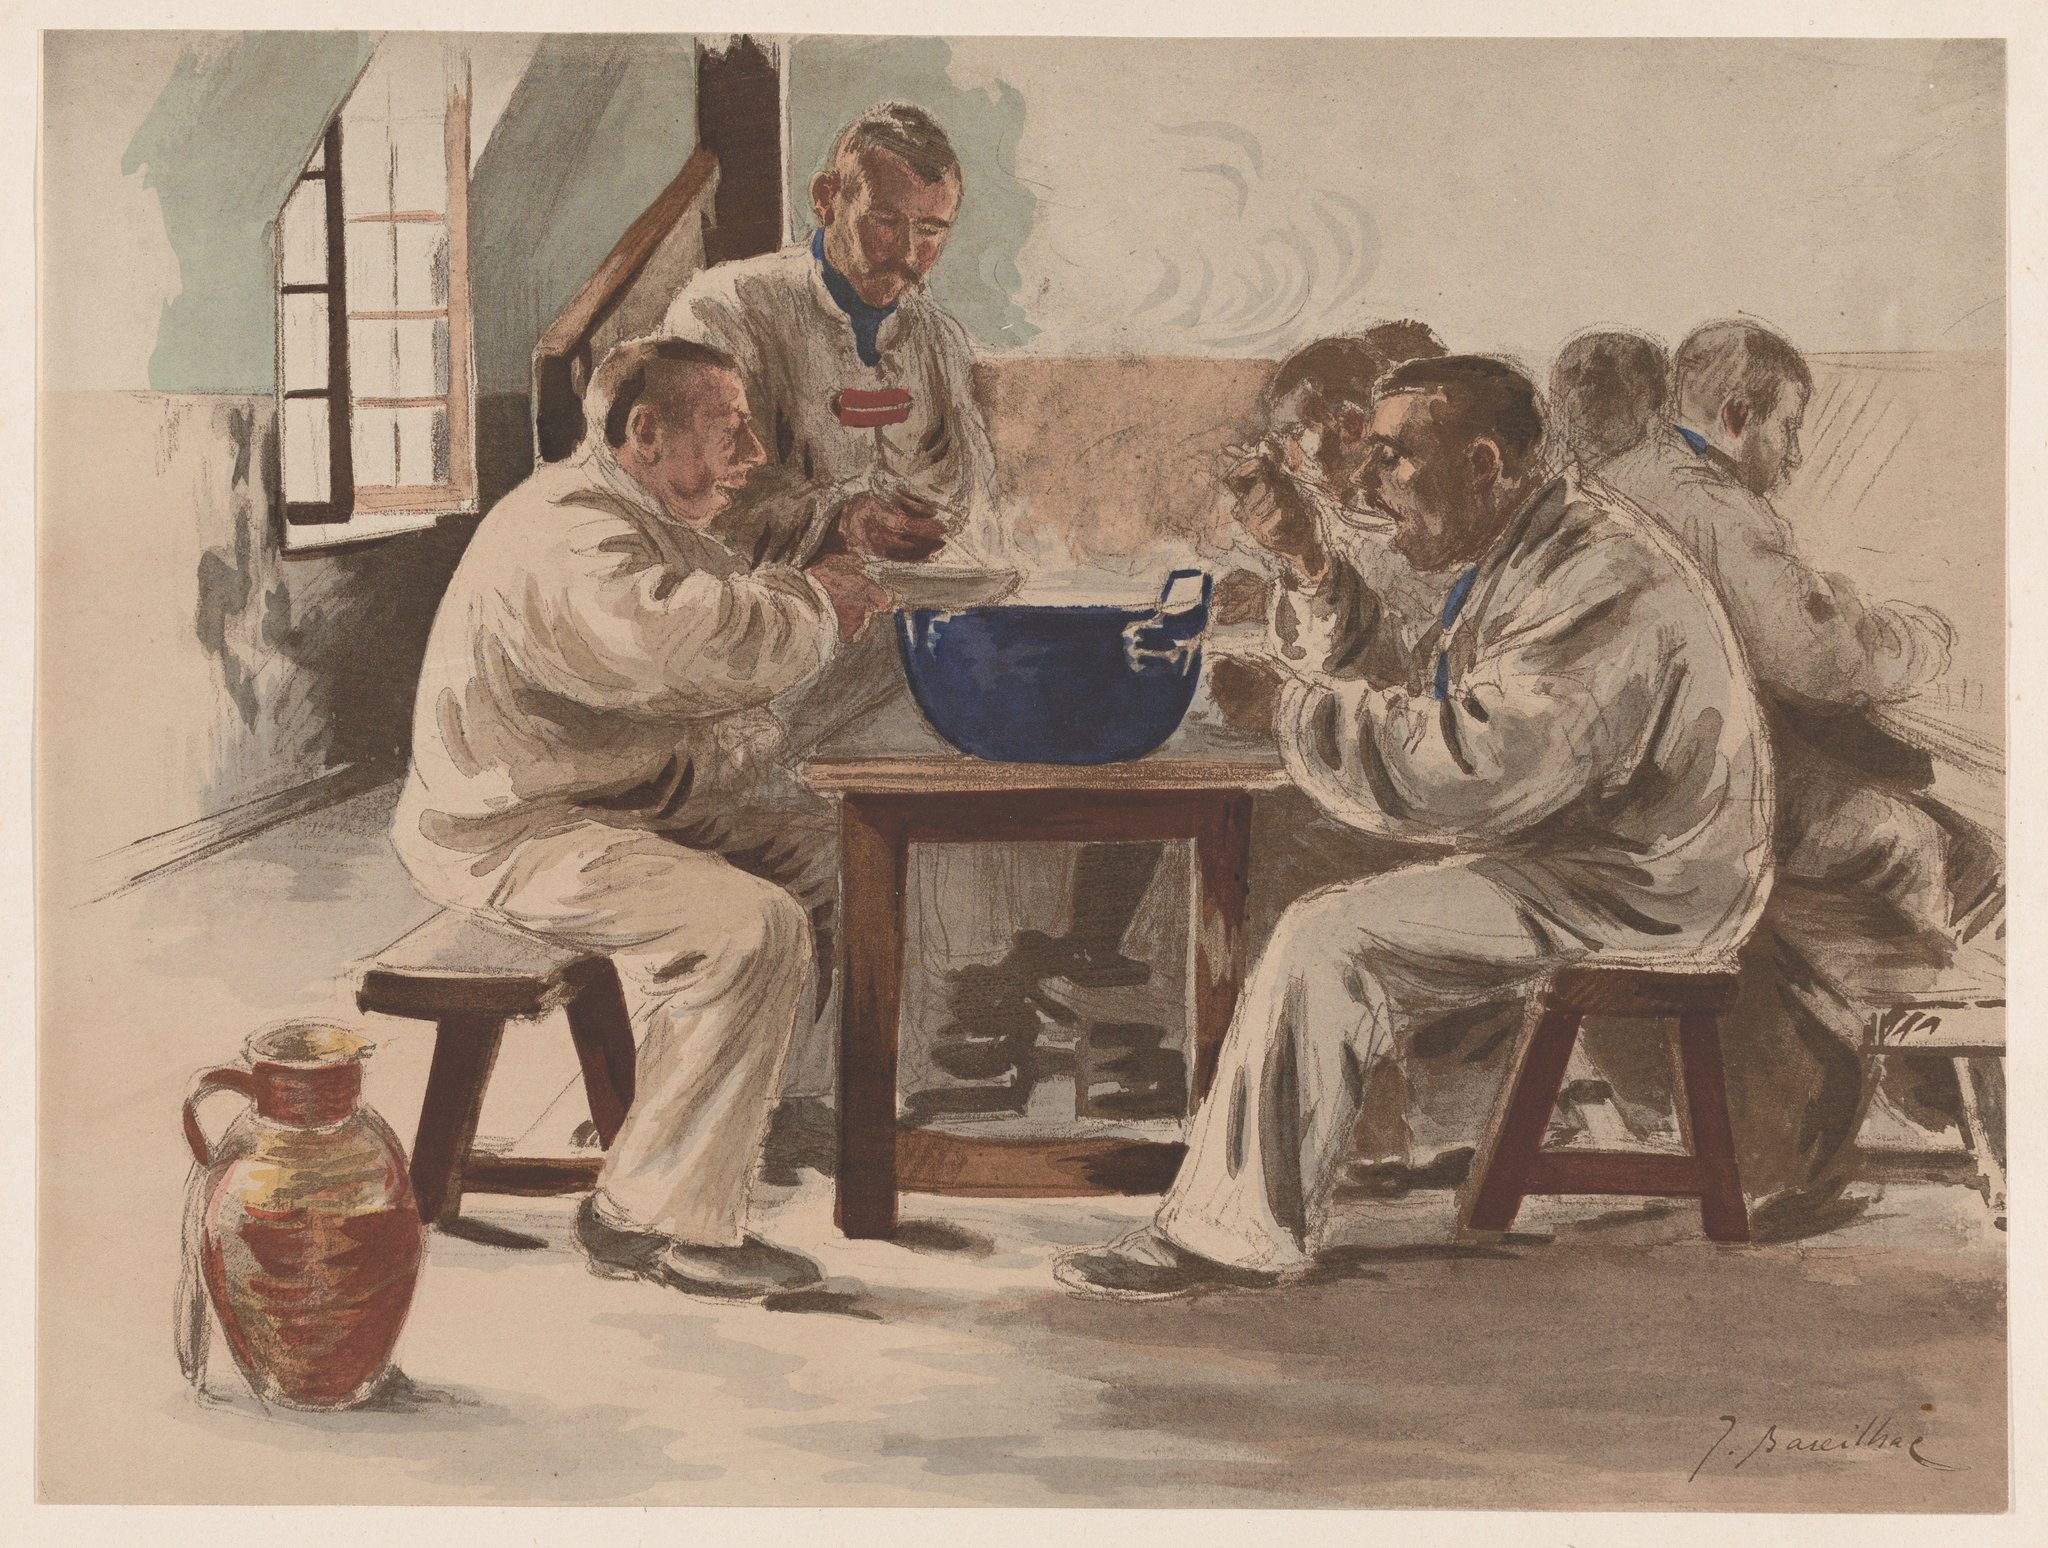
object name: print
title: La soupe à la chambrée, from "L'Estampe Moderne"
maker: jacques baseilhac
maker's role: artist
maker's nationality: french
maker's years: 1874-1903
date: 1898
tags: food,interiors,men,tables,eating